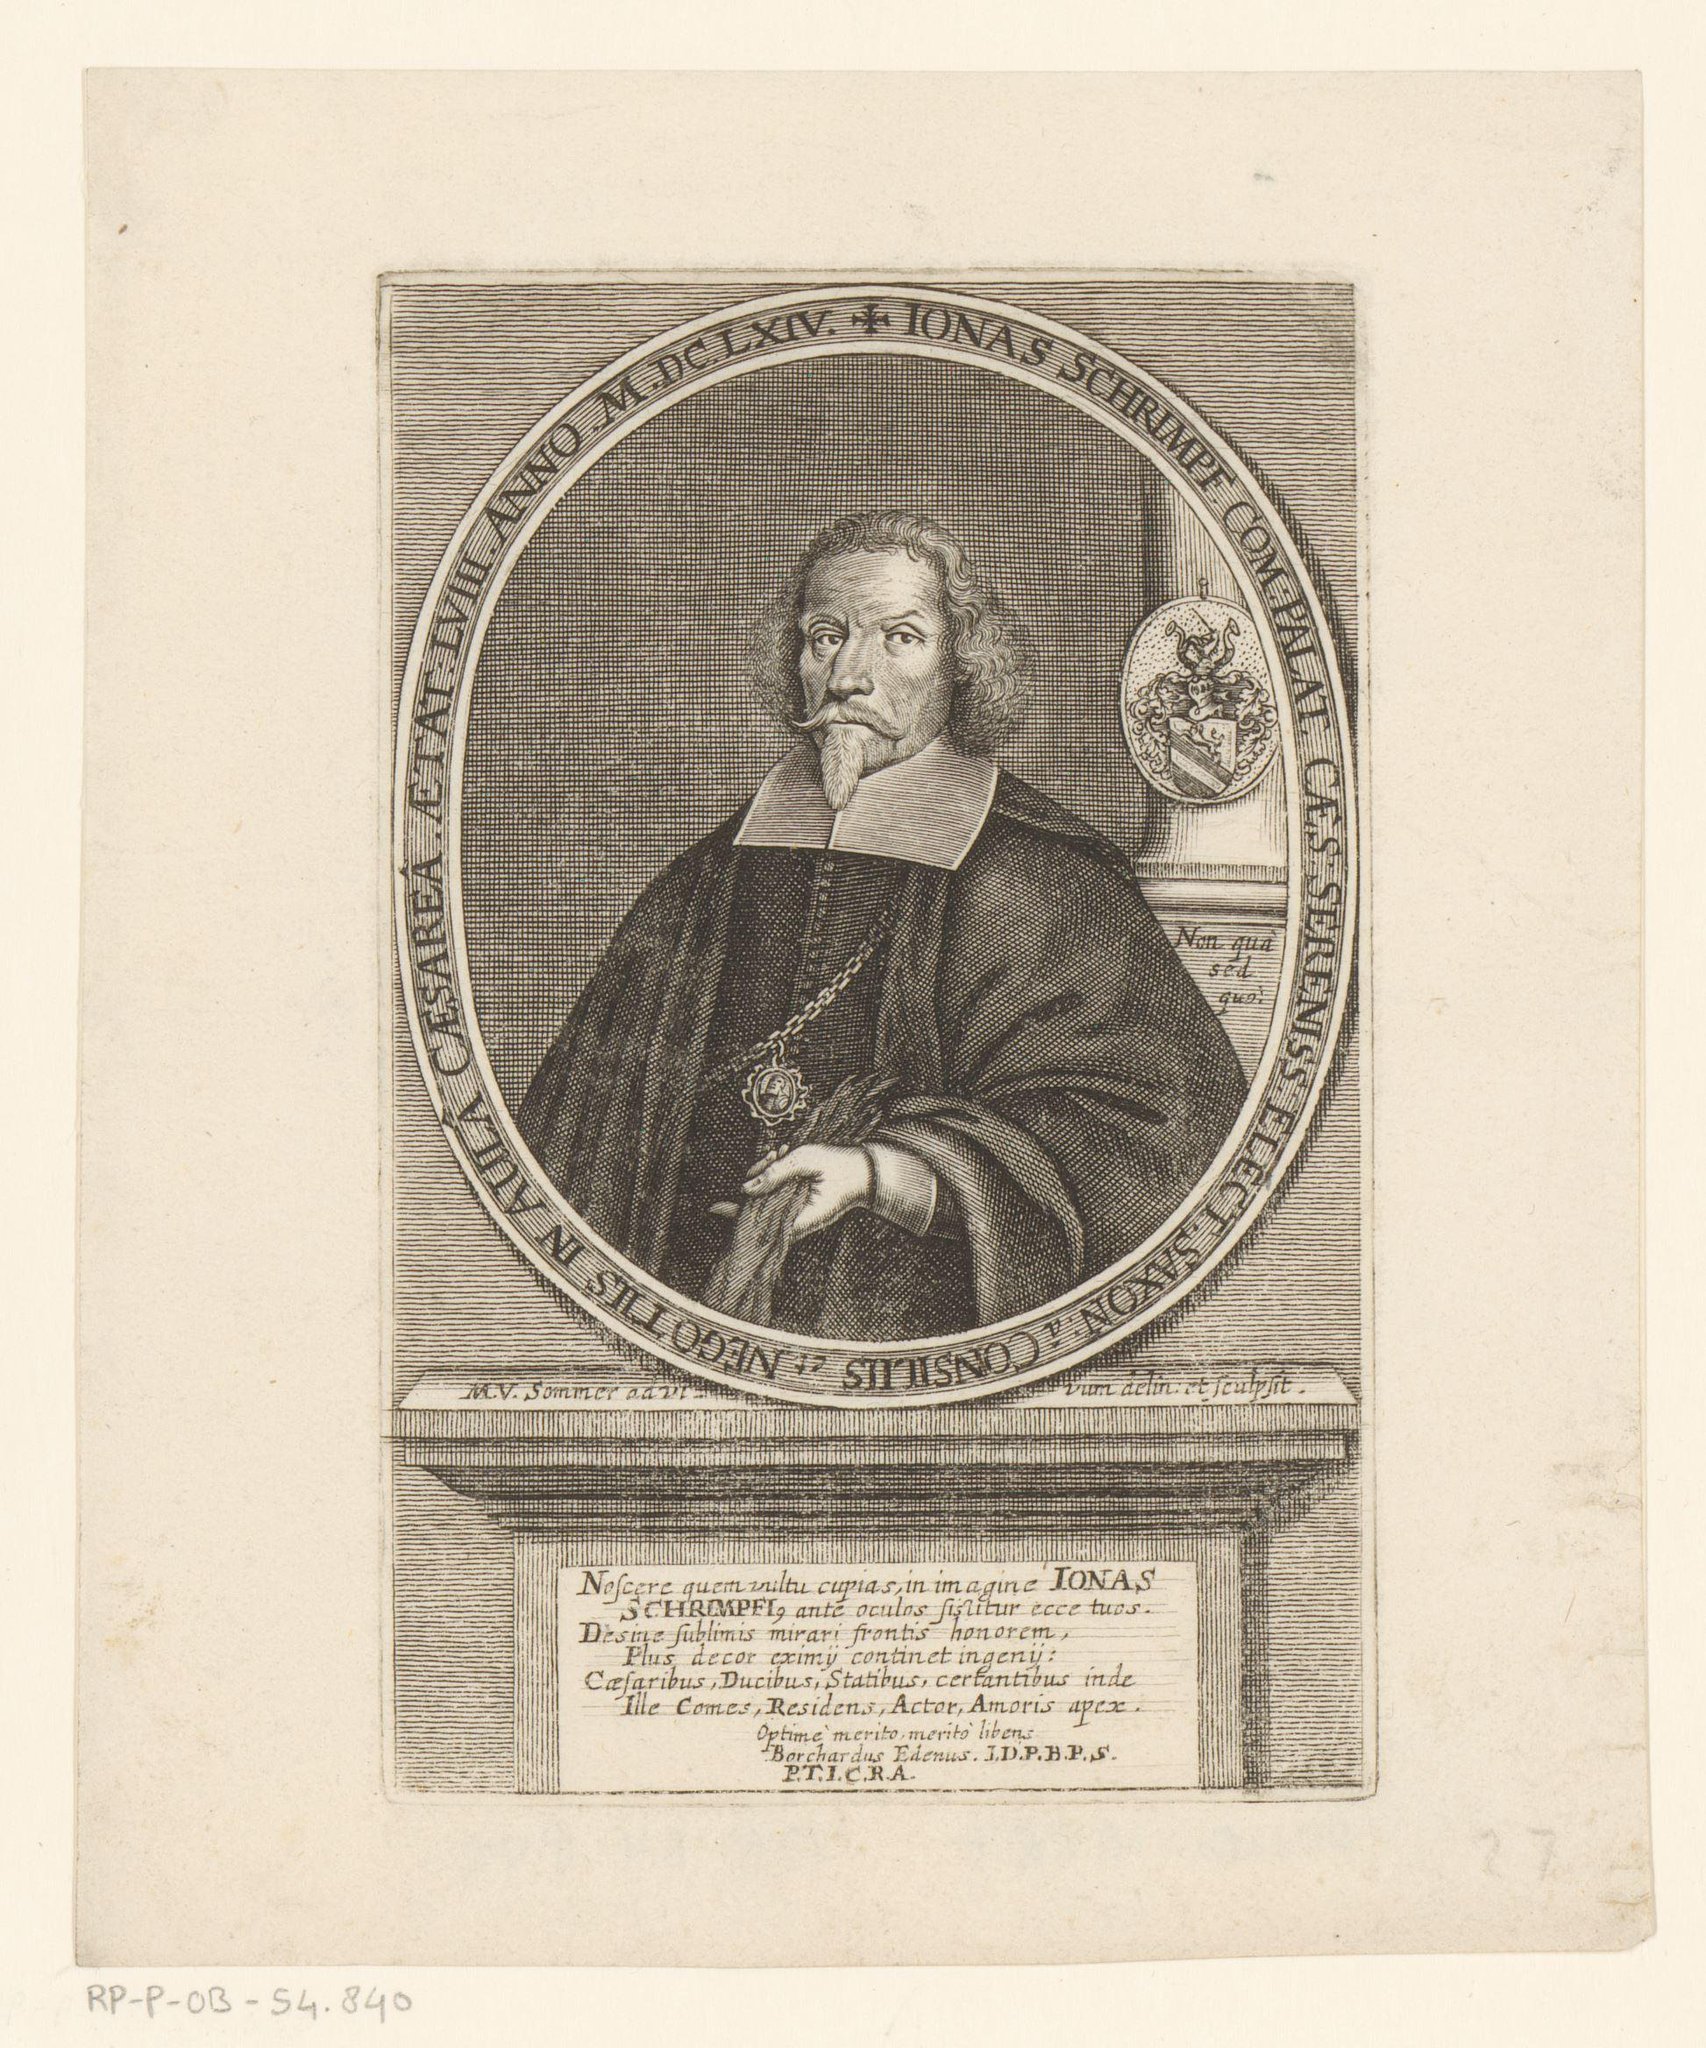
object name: print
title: Portret van Jonas Schrimpf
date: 1643-1672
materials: paper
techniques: engraving, etching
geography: germany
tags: gloves, mittens, etc., historical persons, book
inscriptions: collector's mark: Lugt 2228